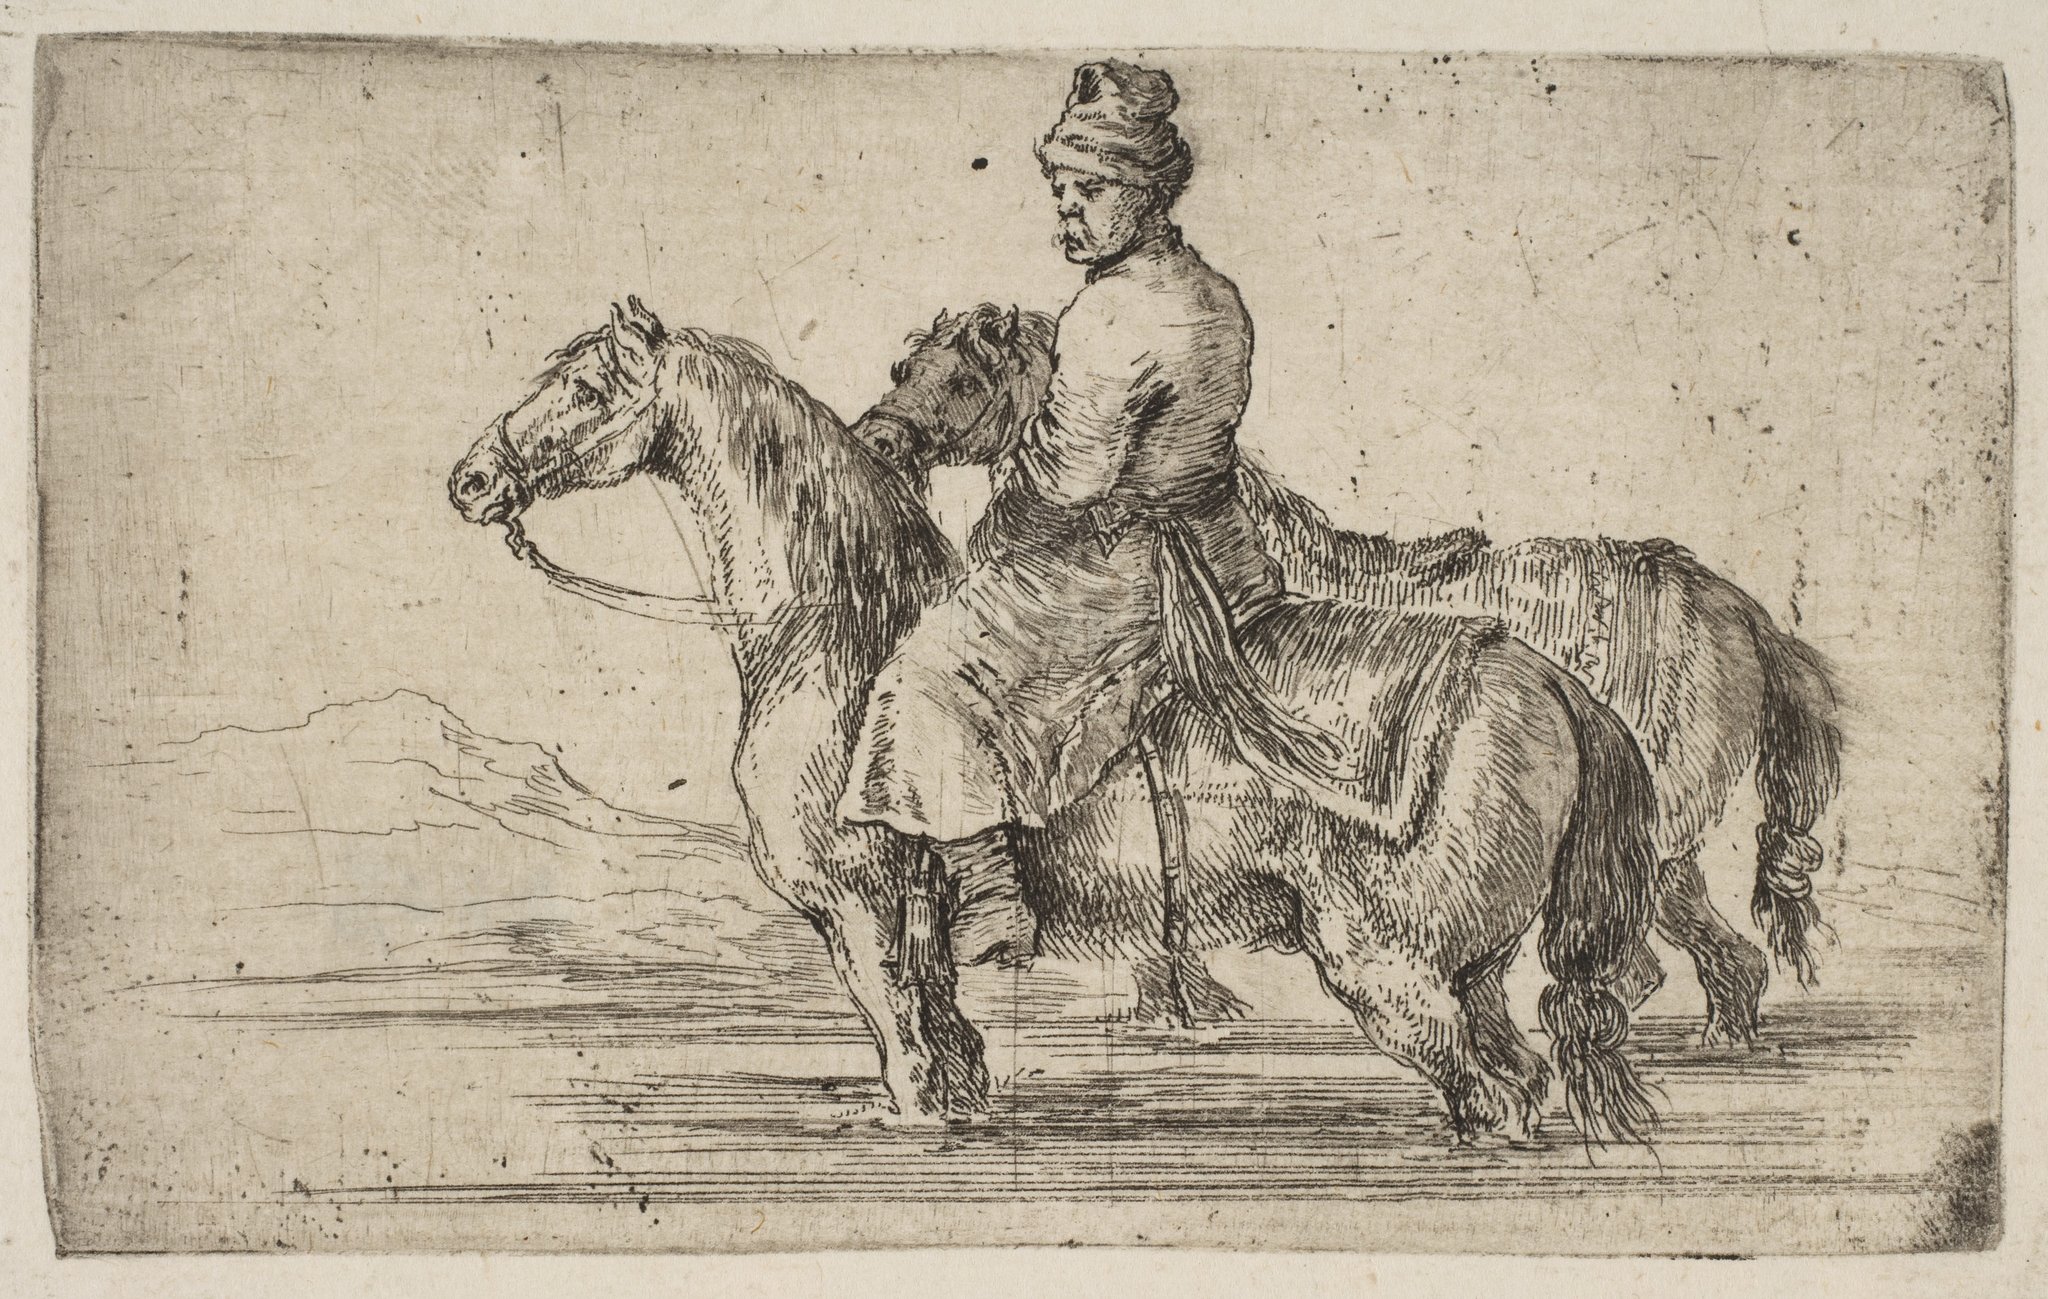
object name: print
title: A Polish Groom Bathing Horses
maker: stefano della bella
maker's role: artist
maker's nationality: italian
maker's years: 1610-1664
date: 1662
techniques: etching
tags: men,horses